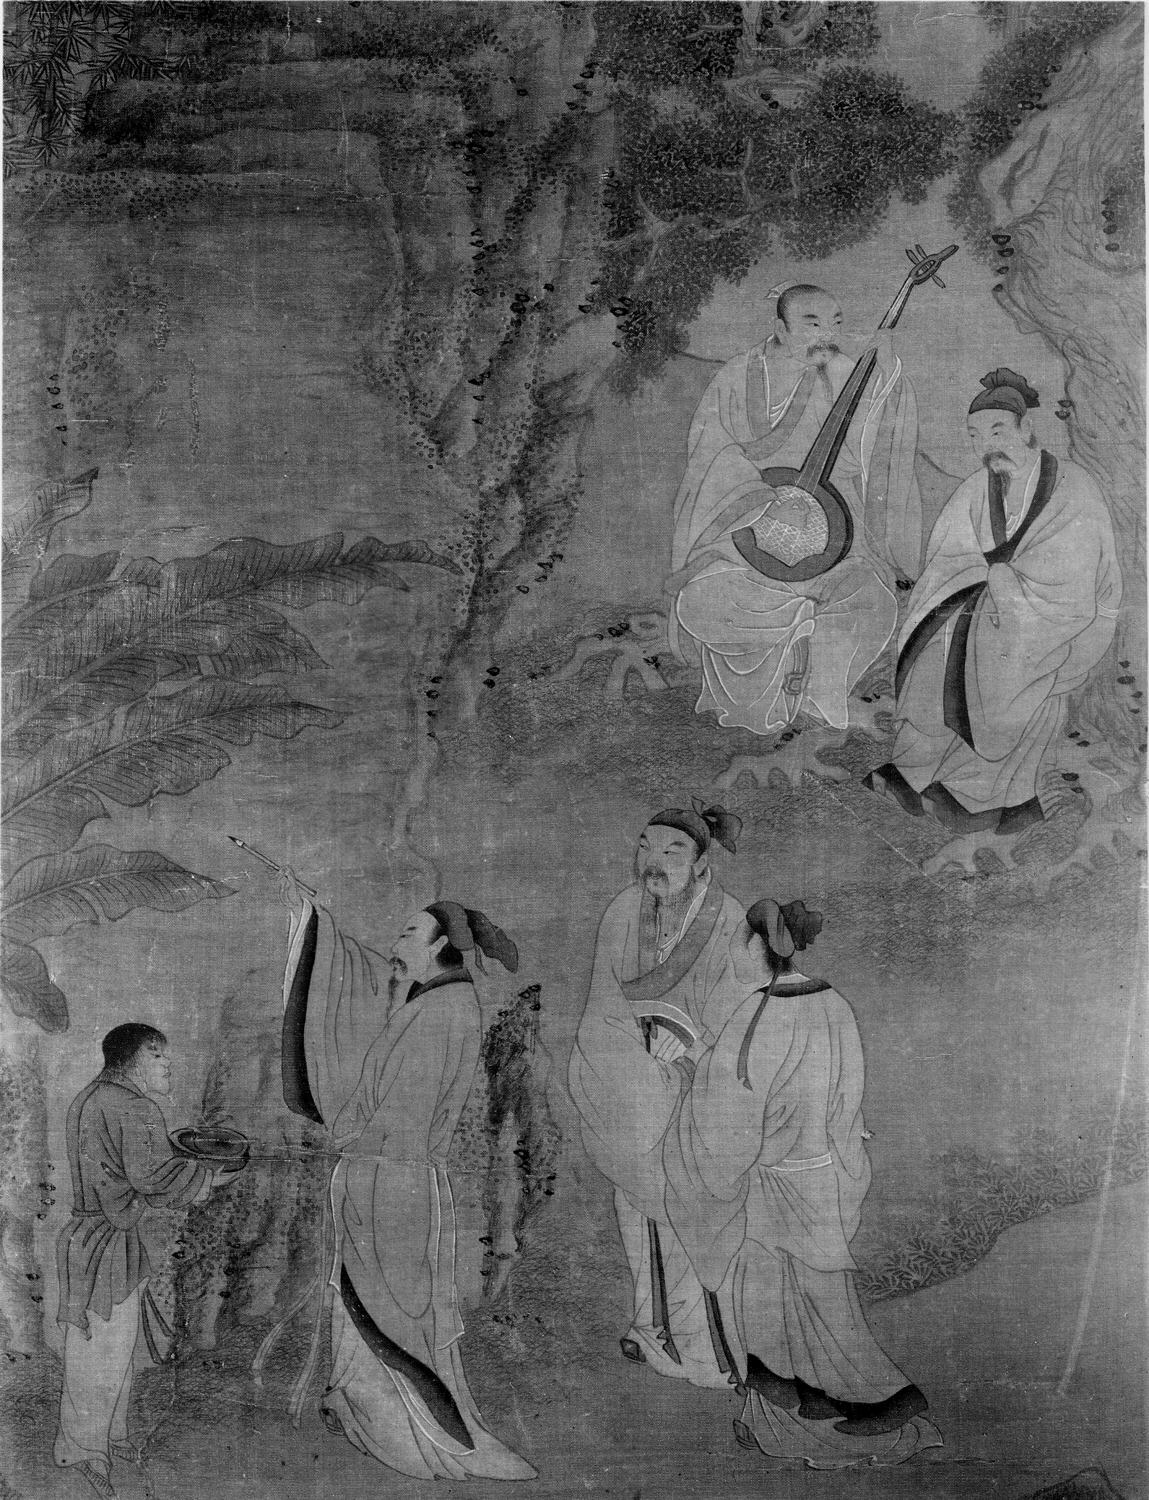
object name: hanging scroll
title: Gathering of Scholars at the Western Garden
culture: chinese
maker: unidentified artist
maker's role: artist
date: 1368-1911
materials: ink, silk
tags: musical instruments,men